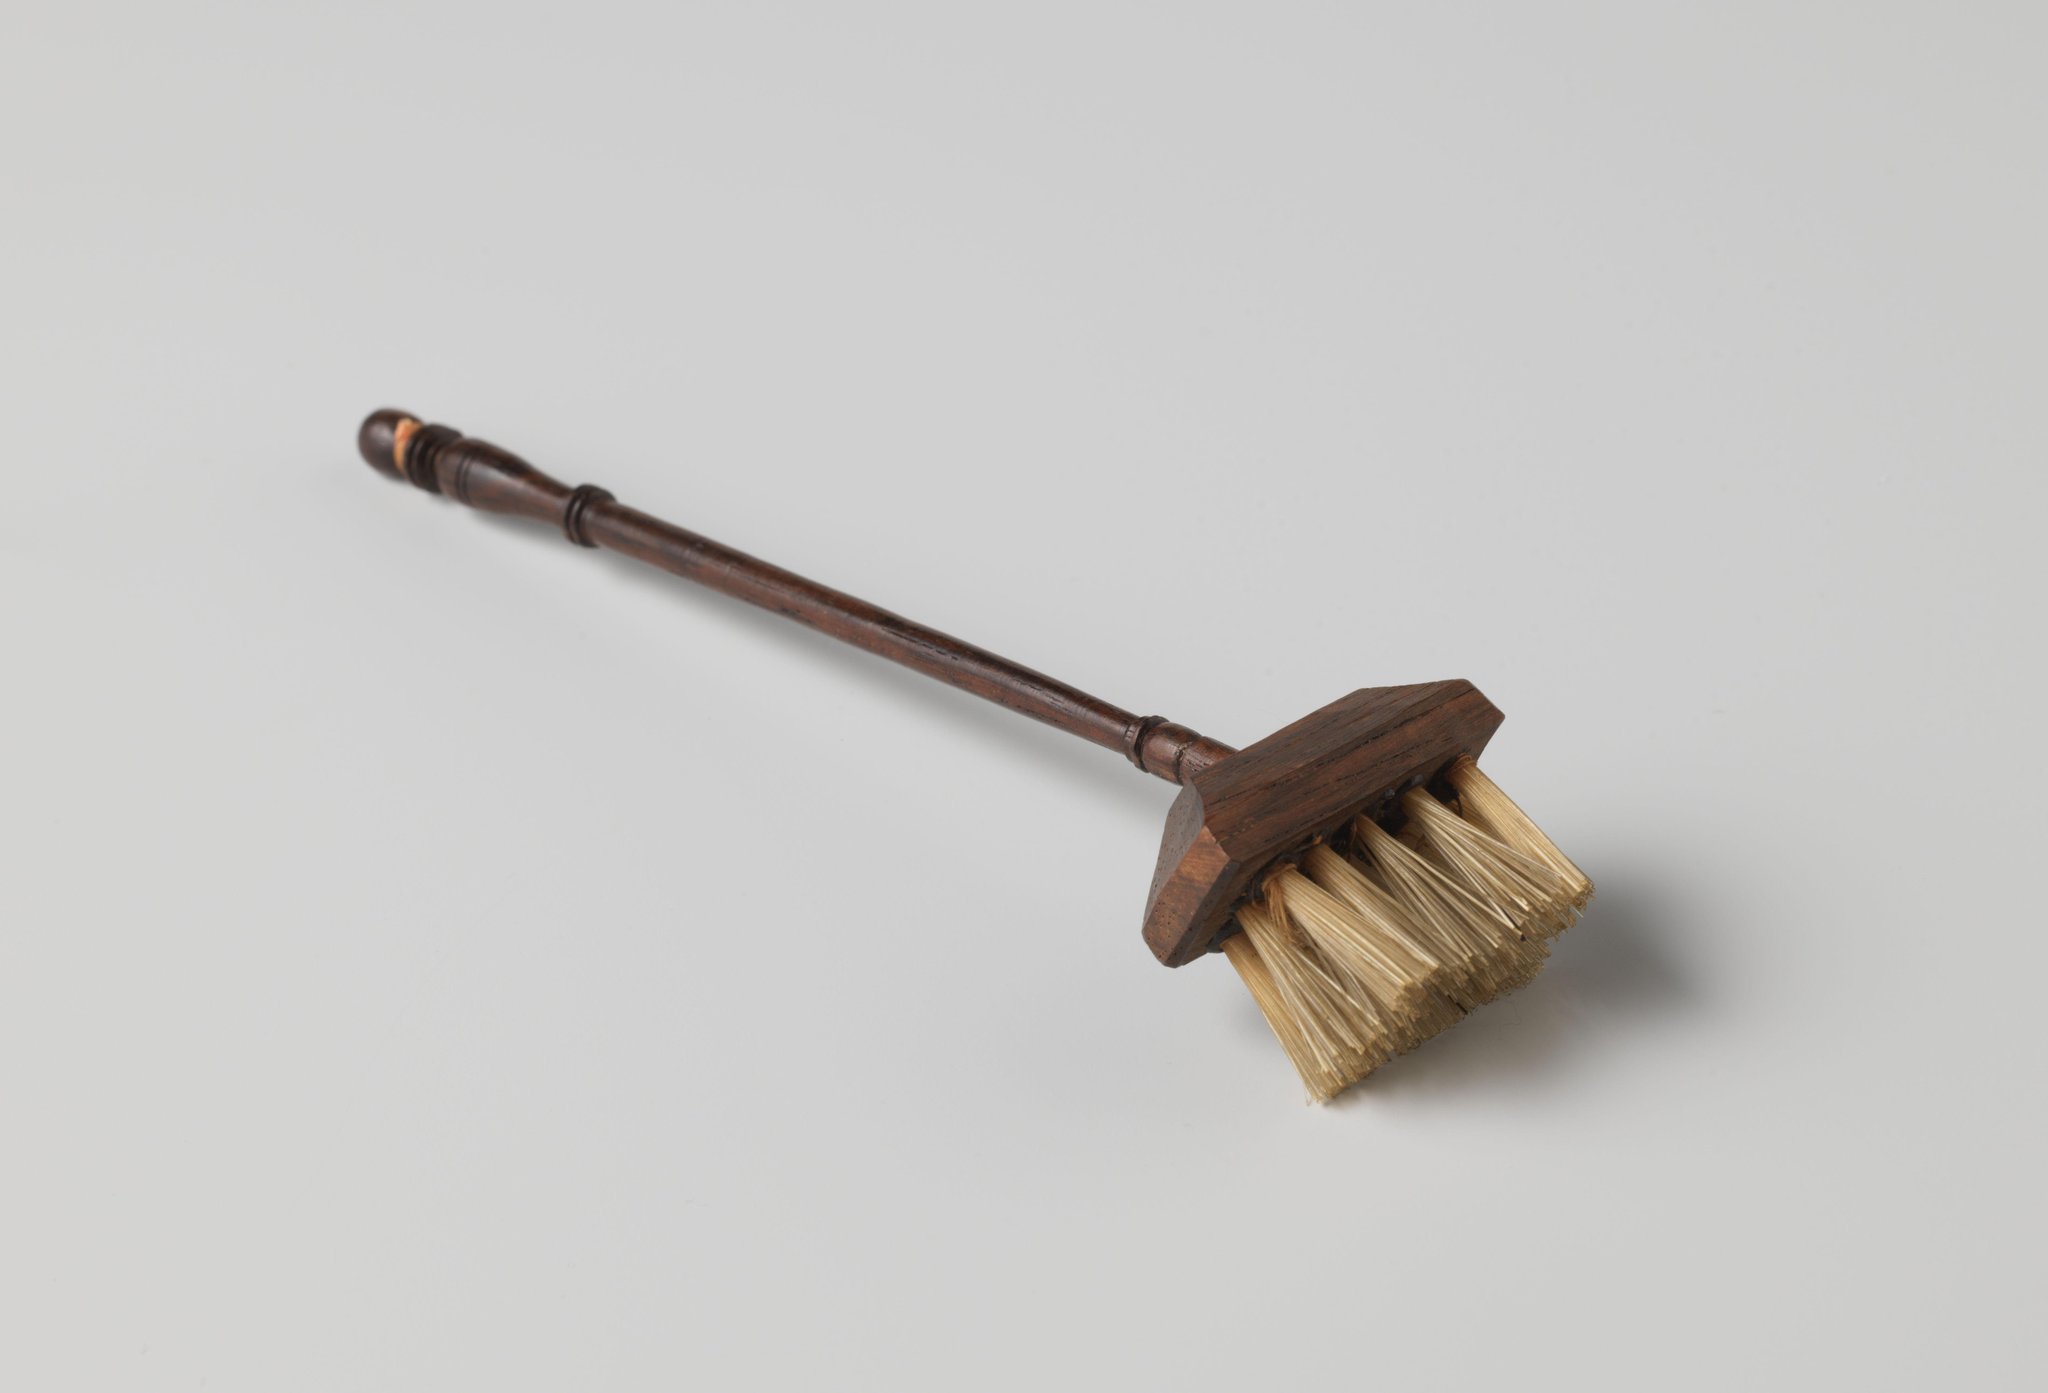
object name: broom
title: Luiwagen met geprofileerde steel, waaraan restanten roze band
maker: Anonymous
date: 1675-1699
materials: wood, silk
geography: amsterdam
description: Luiwagen van palissanderhout en varkenshaar; geprofileerde lange steel waaraan resten van roze, zijden band.